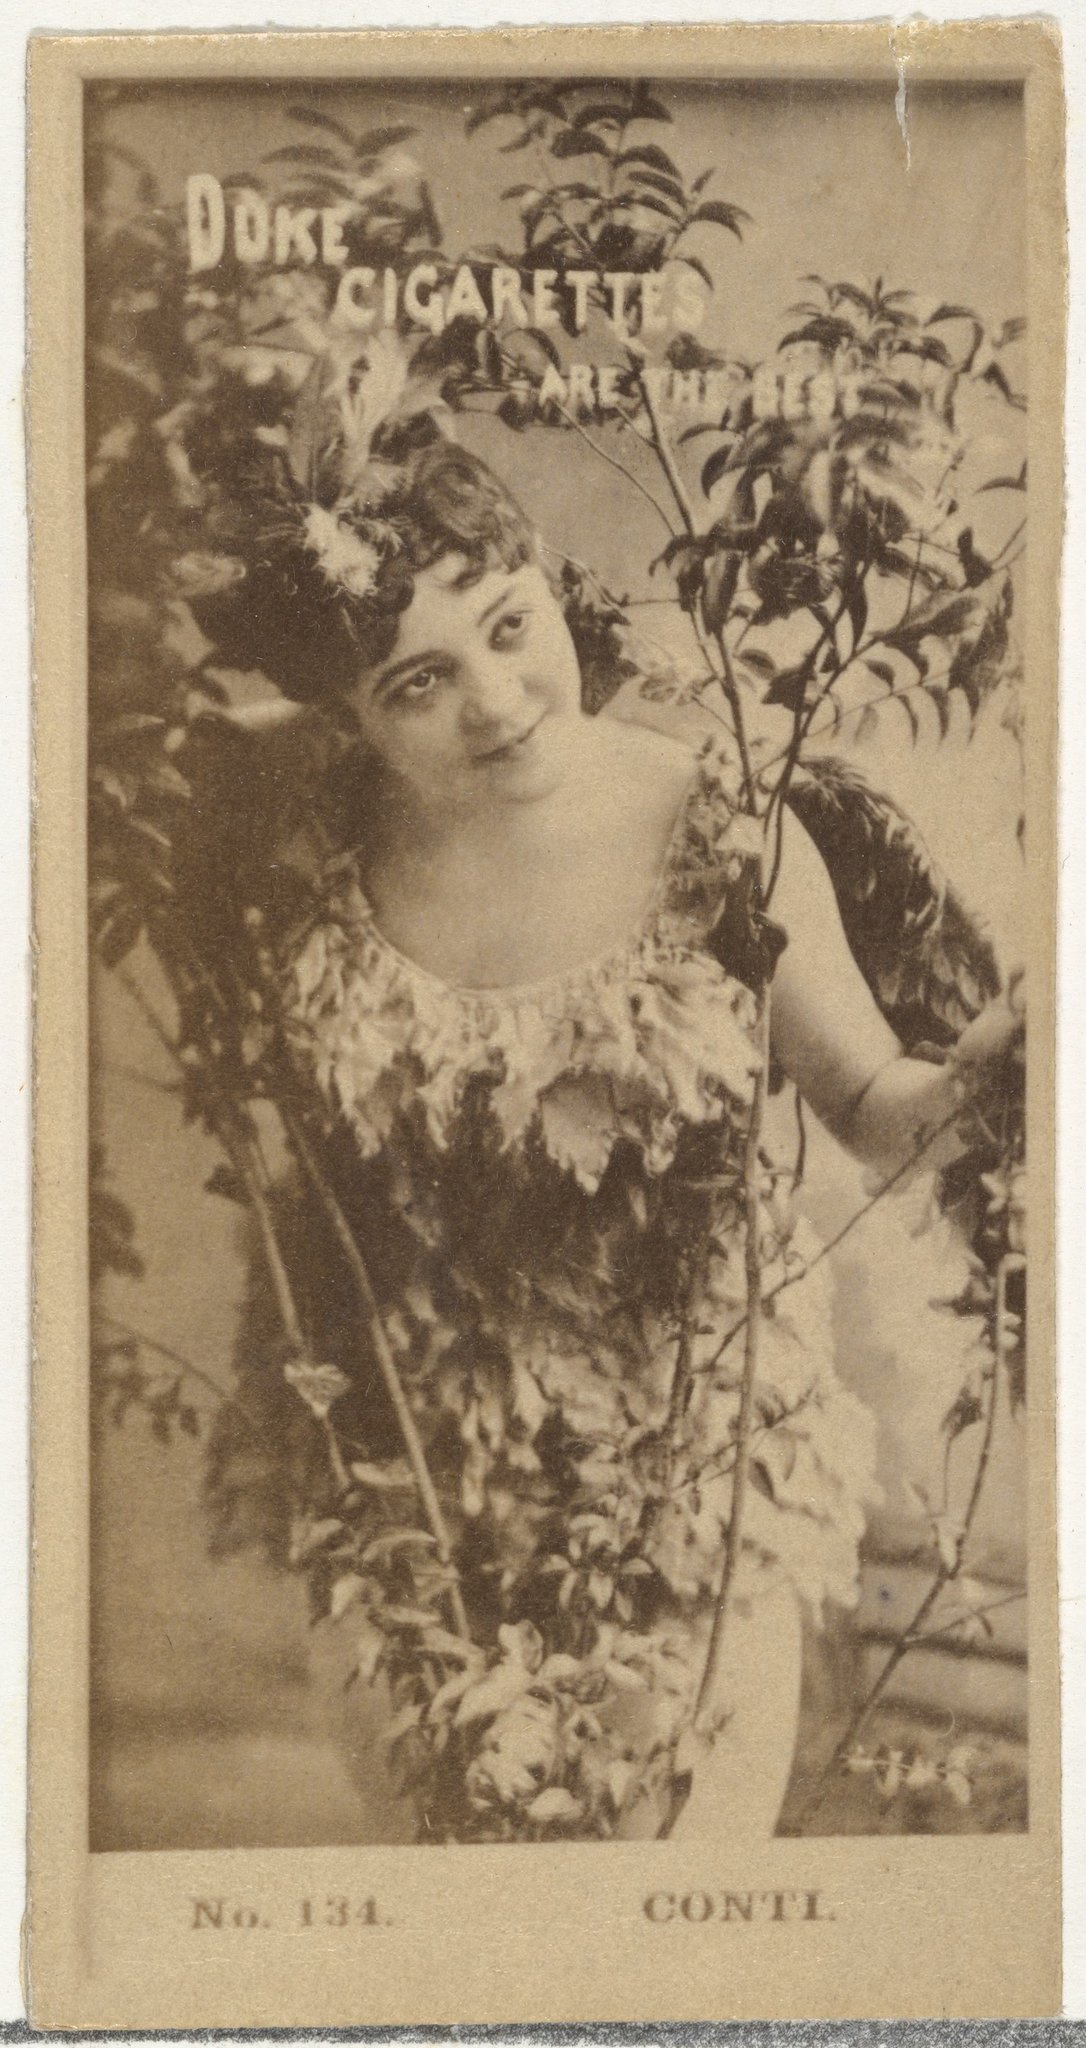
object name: photograph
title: Card Number 134, Conti, from the Actors and Actresses series (N145-6) issued by Duke Sons & Co. to promote Duke Cigarettes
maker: w. duke, sons & co.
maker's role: publisher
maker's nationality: american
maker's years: 1870-1920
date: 1880-1889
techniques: albumen silver print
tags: portraits,women,actresses